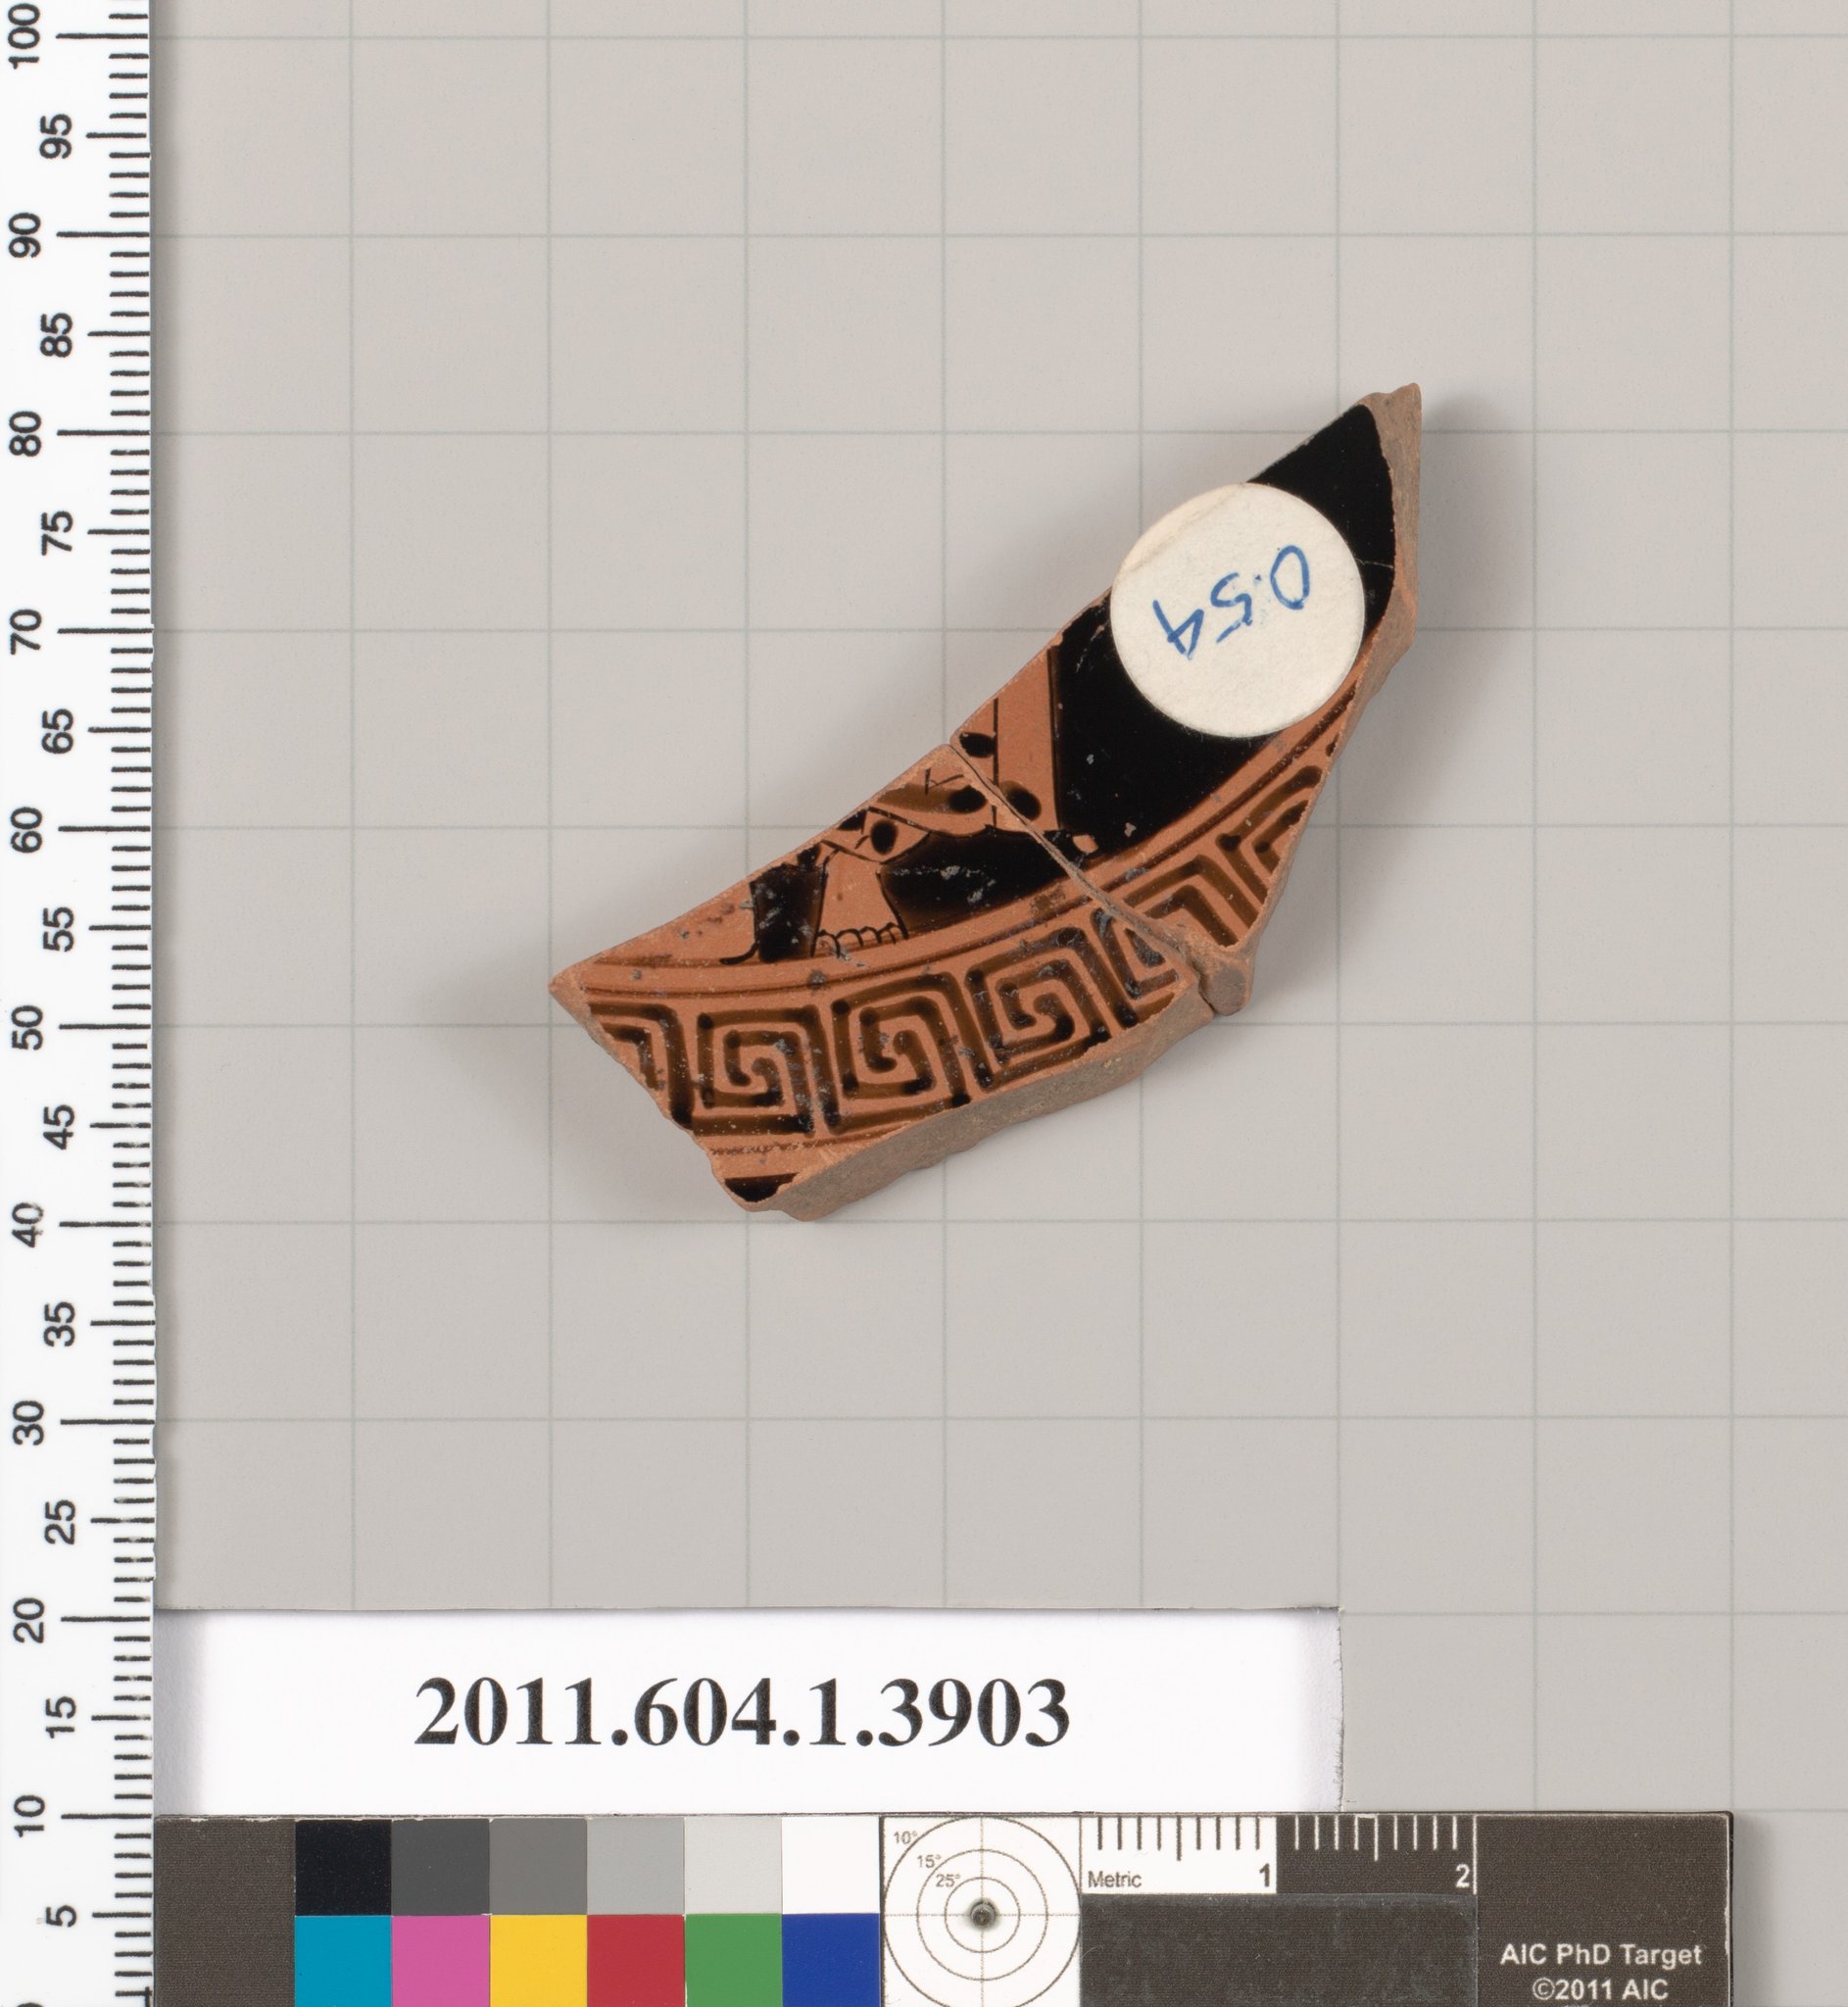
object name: kylix fragment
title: Terracotta fragment of a kylix (drinking cup)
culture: greek, attic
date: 490-470 BCE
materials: terracotta